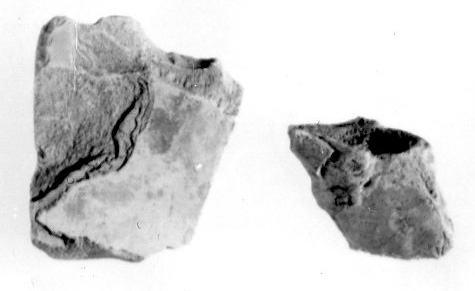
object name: relief fragment, tomb of meketre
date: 1981-1975 BCE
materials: limestone, paint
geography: egypt